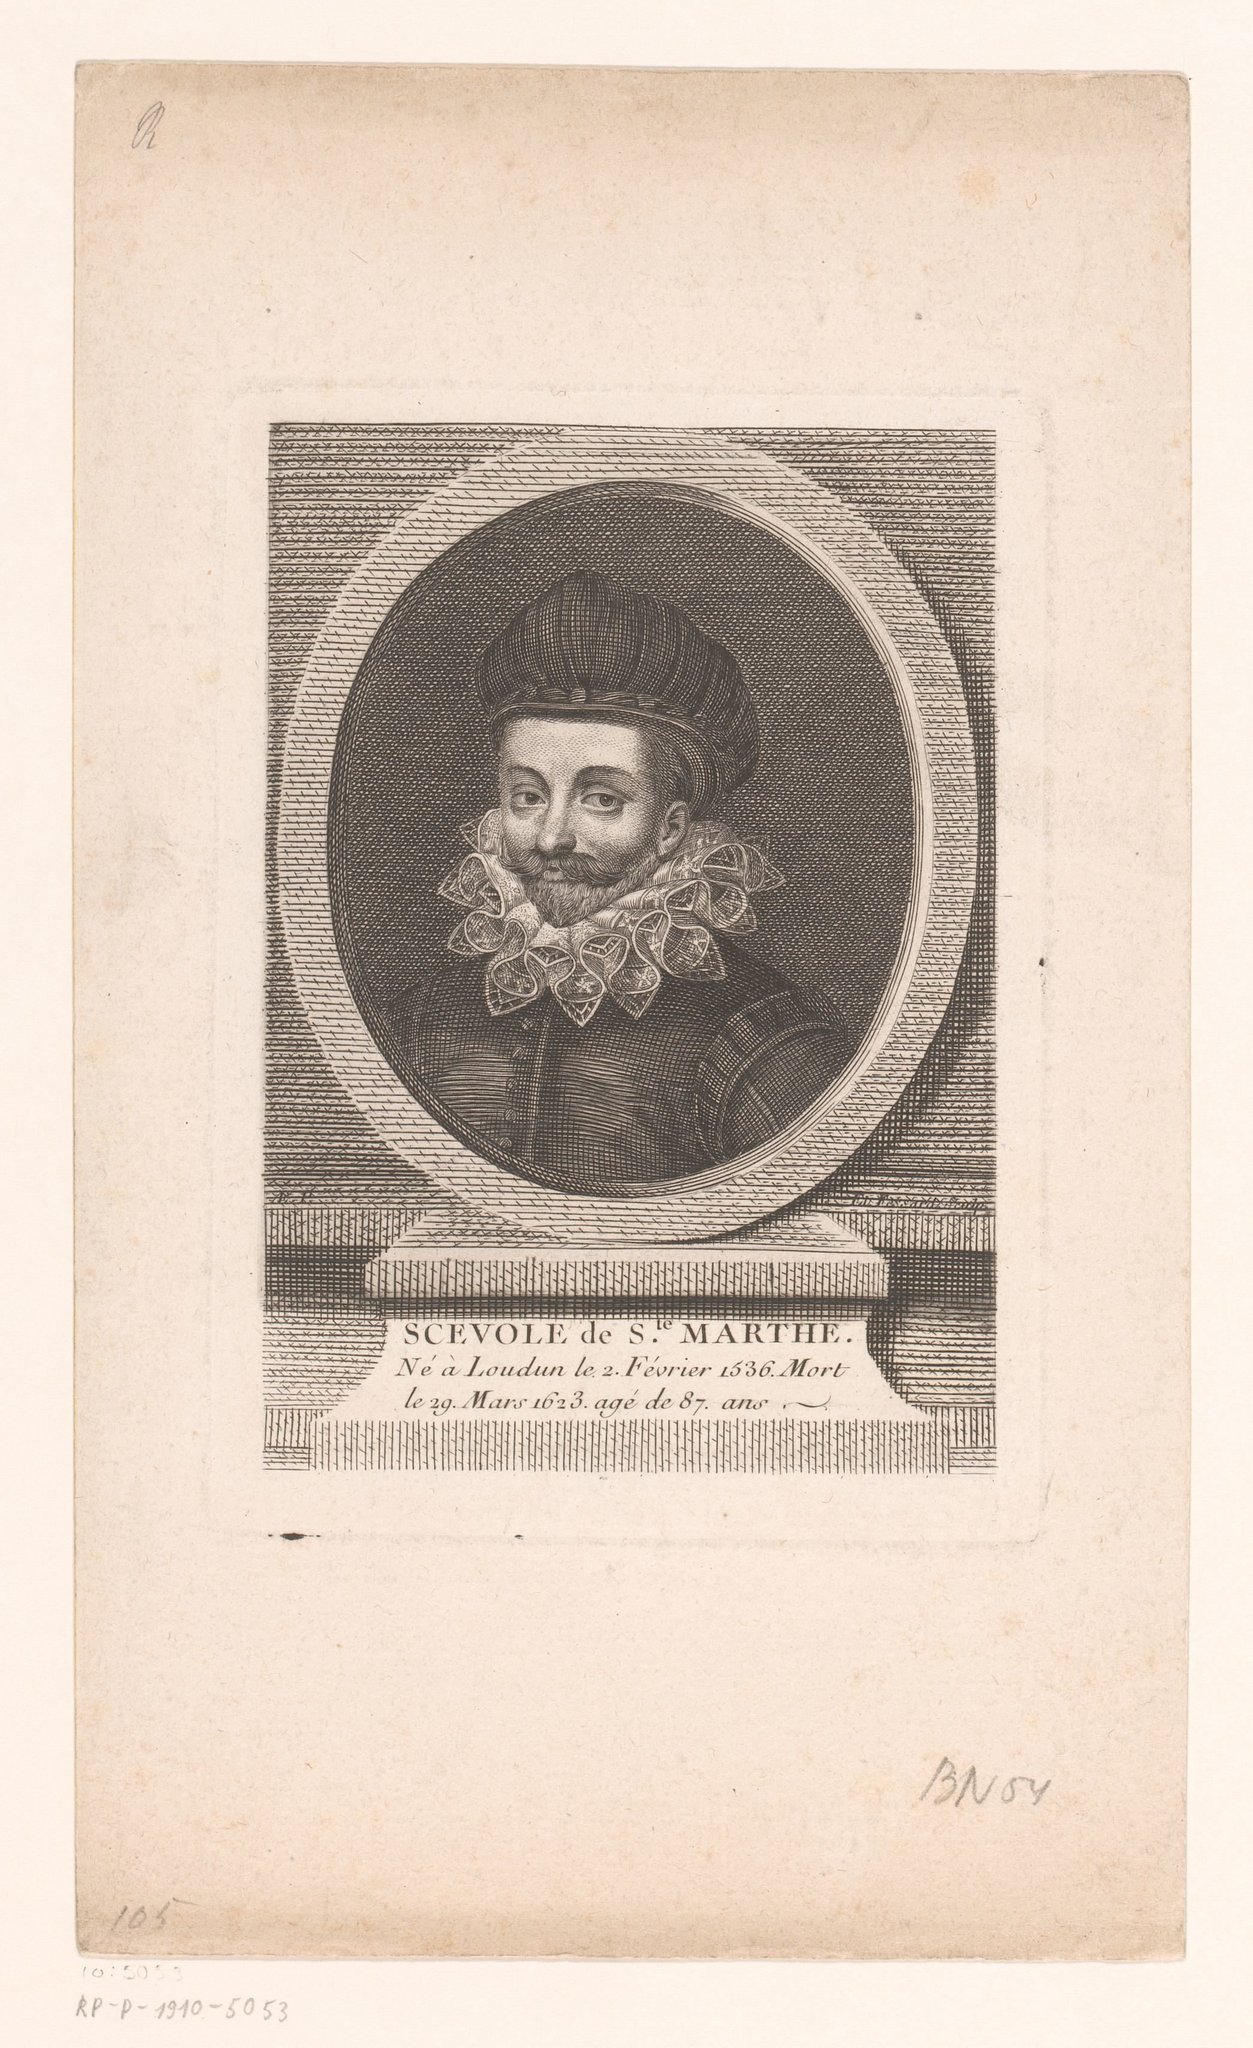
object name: print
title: Scevole de S.te Marthe.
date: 1744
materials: paper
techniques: engraving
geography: france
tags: ornament ~ medallion, historical persons, writer, poet, author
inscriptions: collector's mark: Lugt 2228